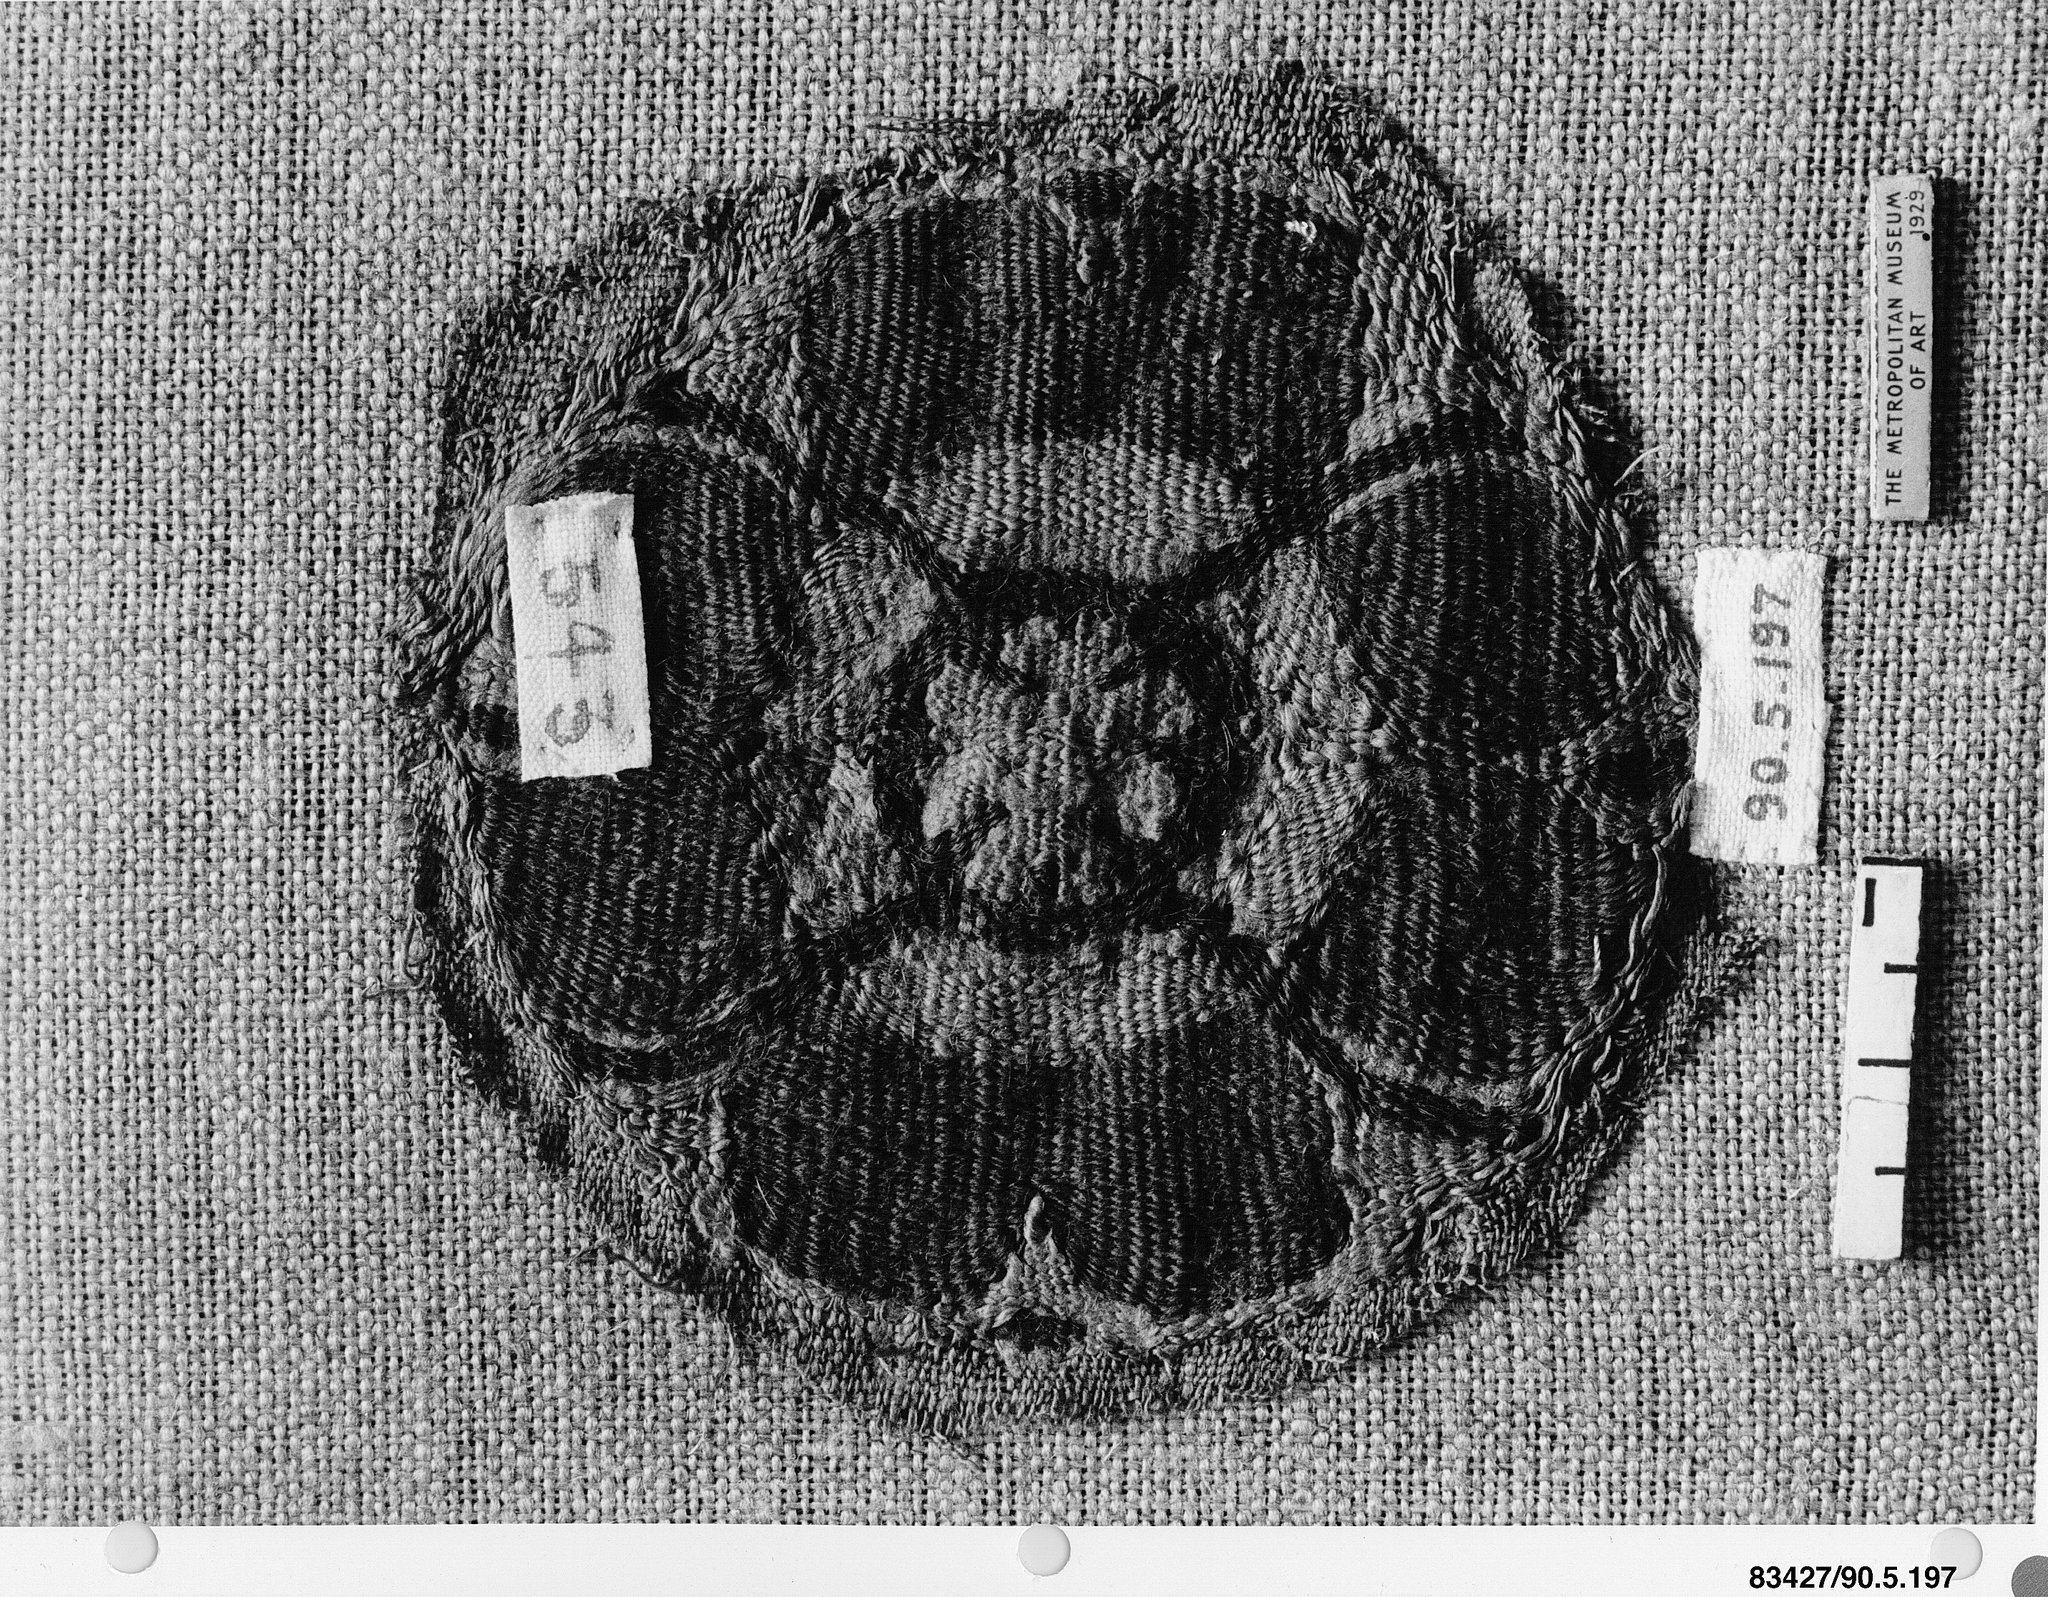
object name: textile fragment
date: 301-500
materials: linen, wool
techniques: weave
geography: egypt